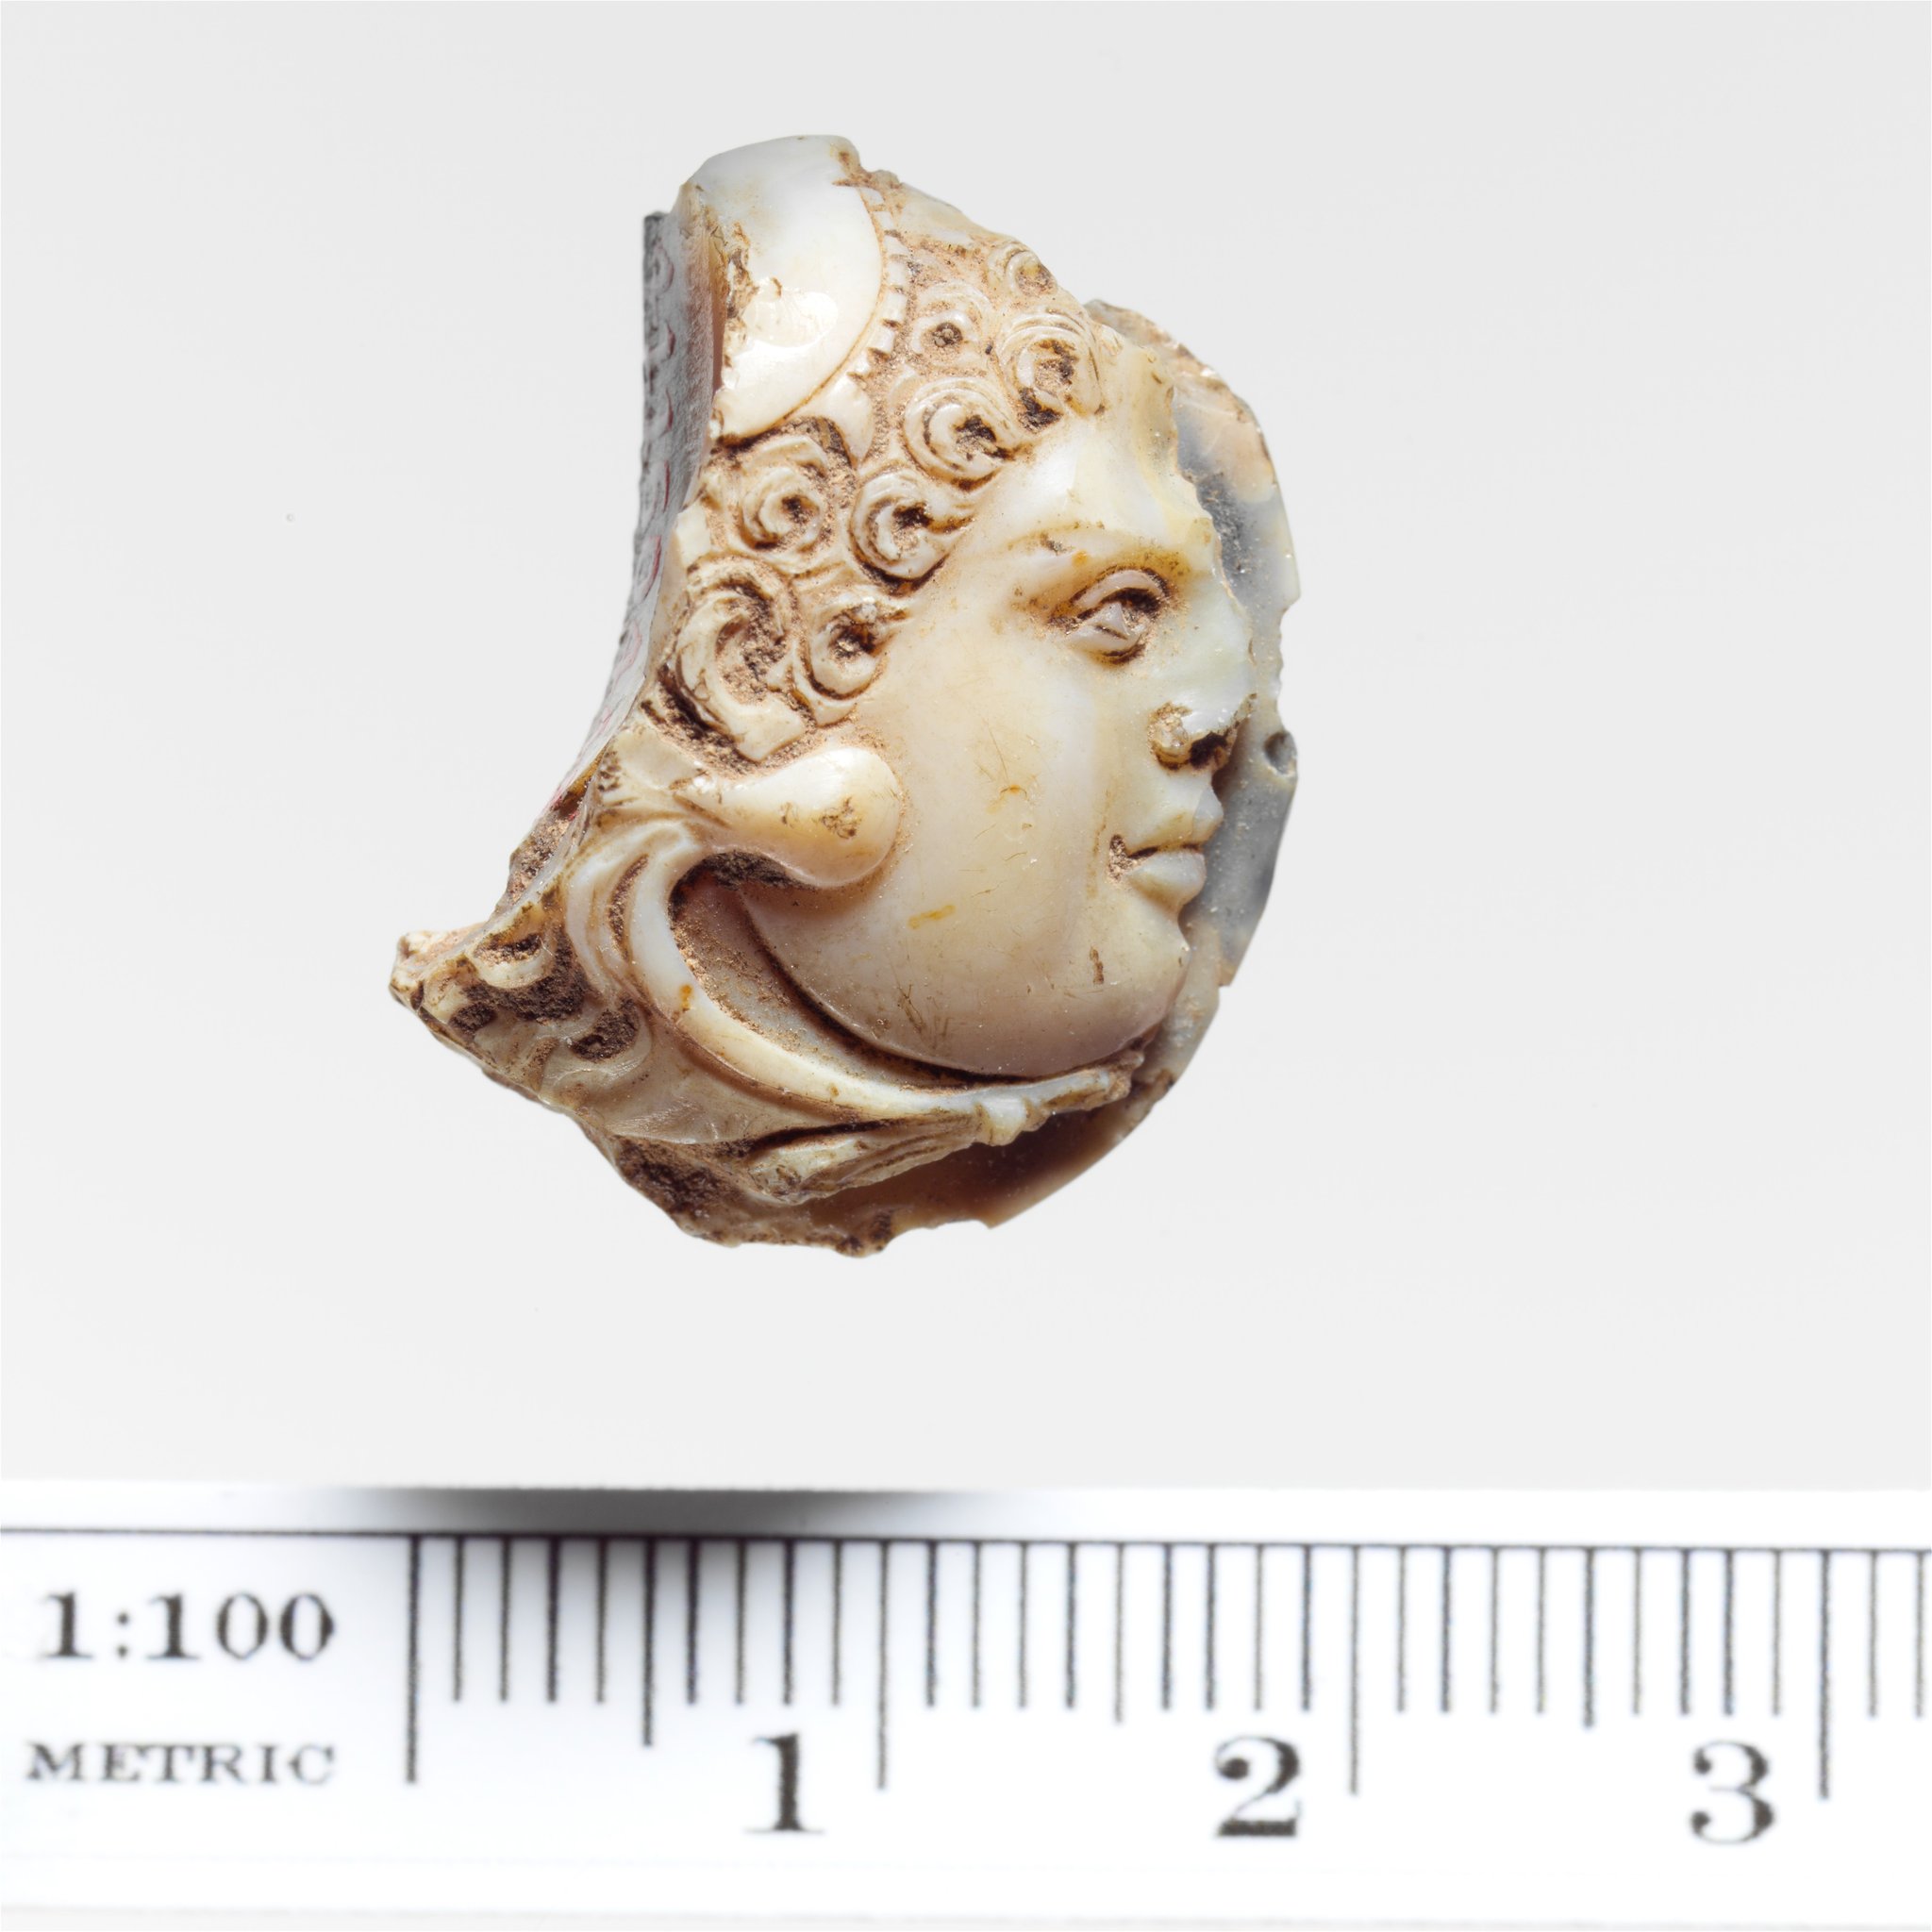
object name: cameo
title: Onyx cameo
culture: roman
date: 34 BCE-300 CE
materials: onyx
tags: alexander the great,profiles